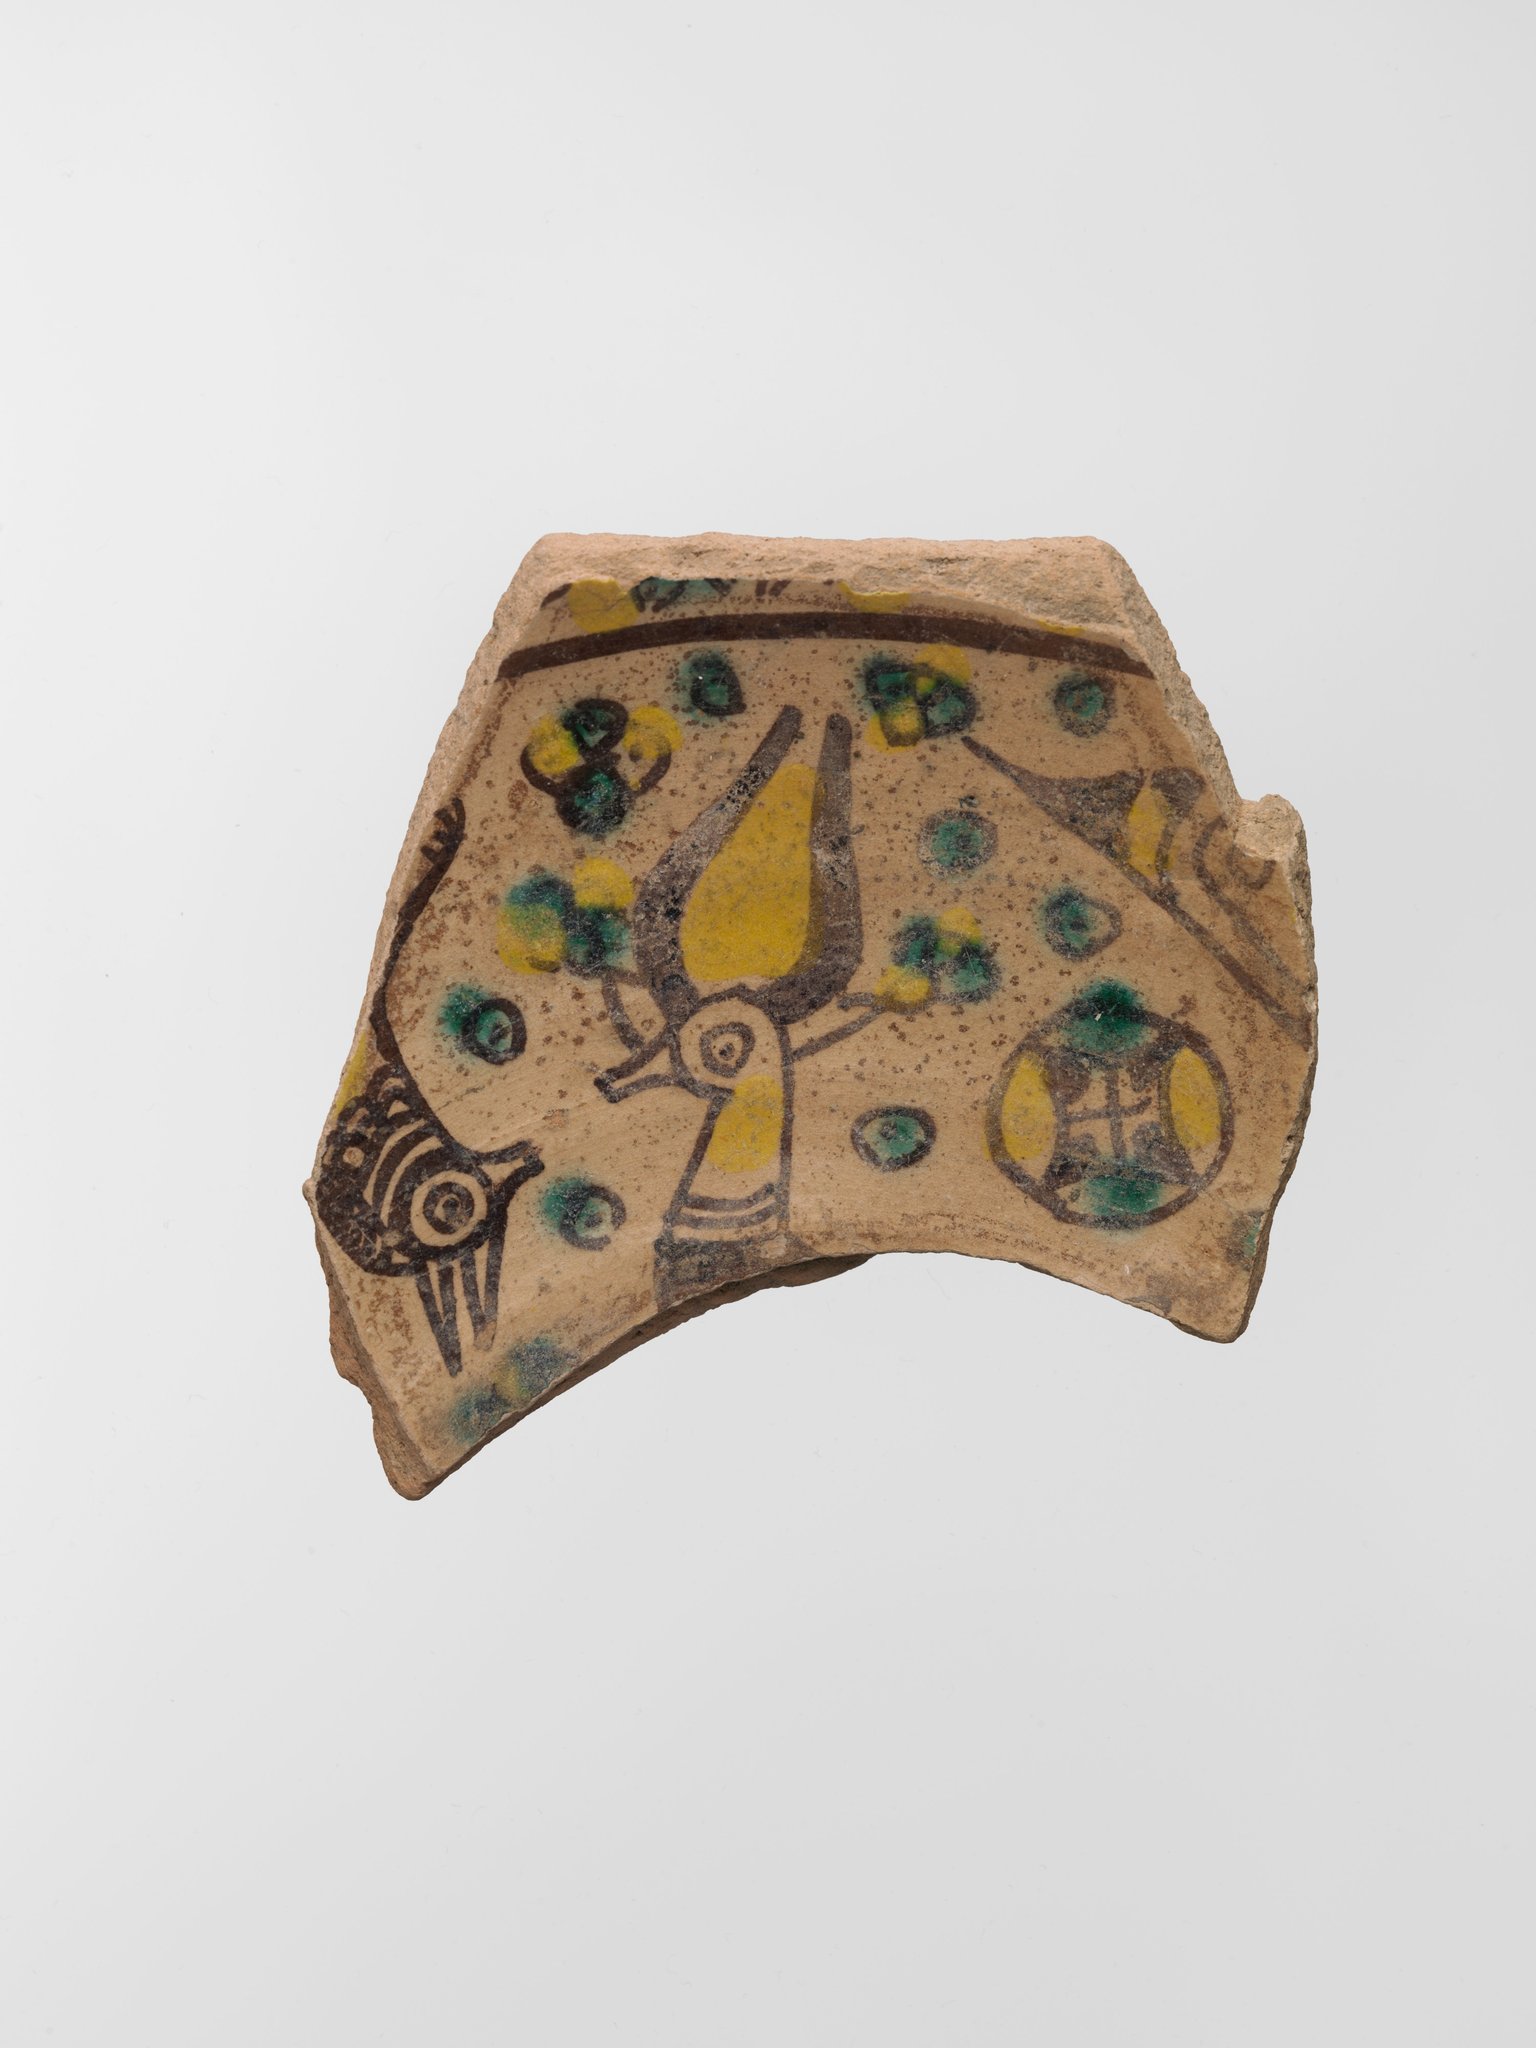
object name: fragment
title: Buff Ware Fragment with Horned Animals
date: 801-1000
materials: earthenware, glaze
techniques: polychrome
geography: iran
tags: animals